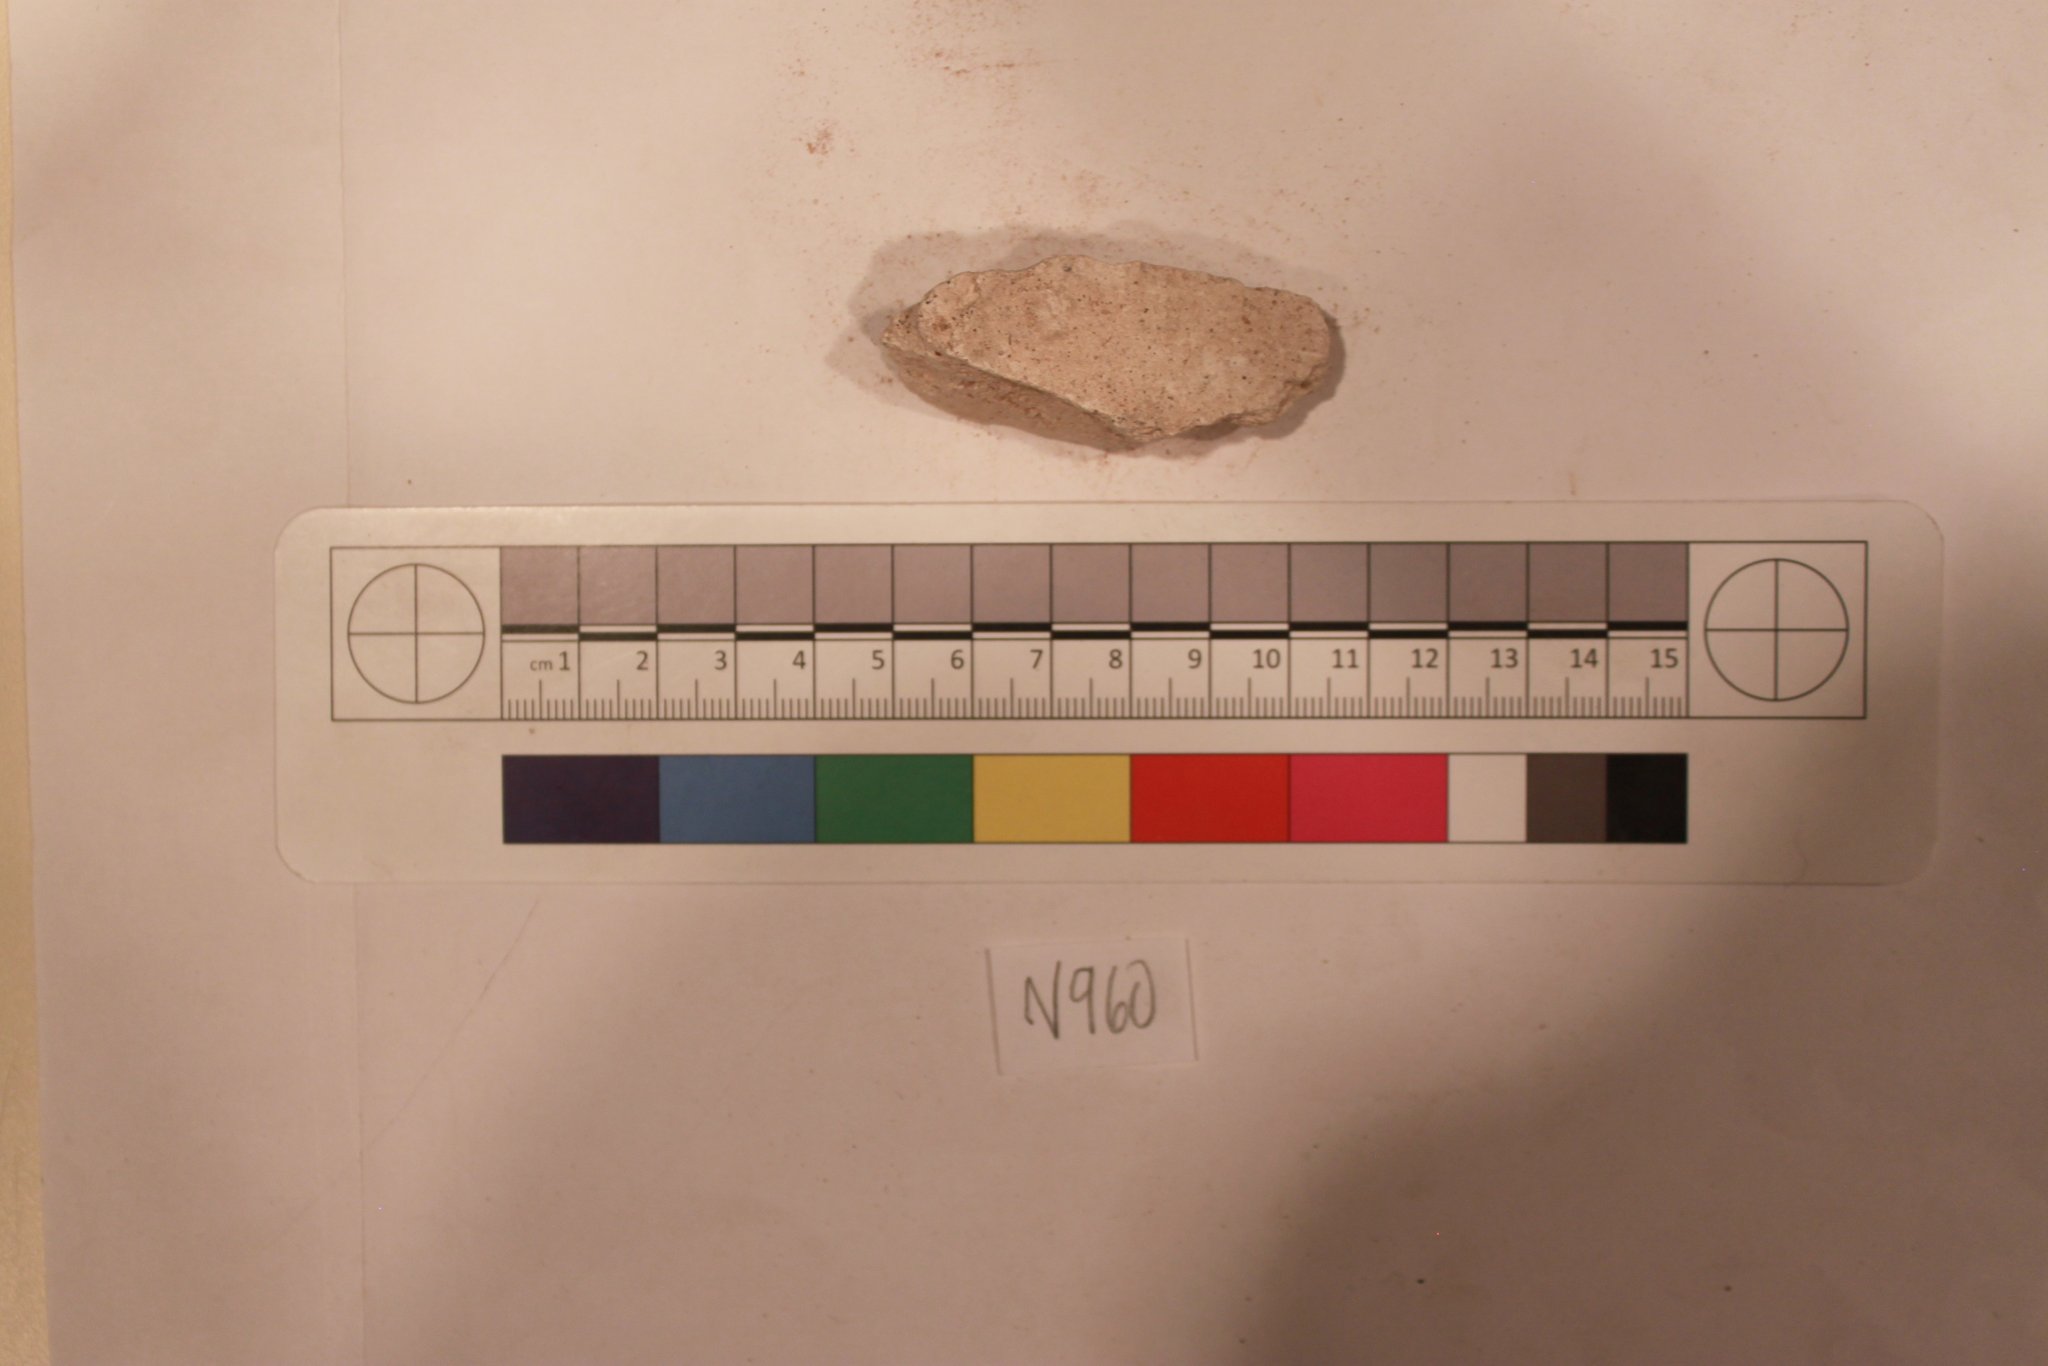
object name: fragment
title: Stucco Fragment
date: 701-1200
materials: plaster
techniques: carving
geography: iran